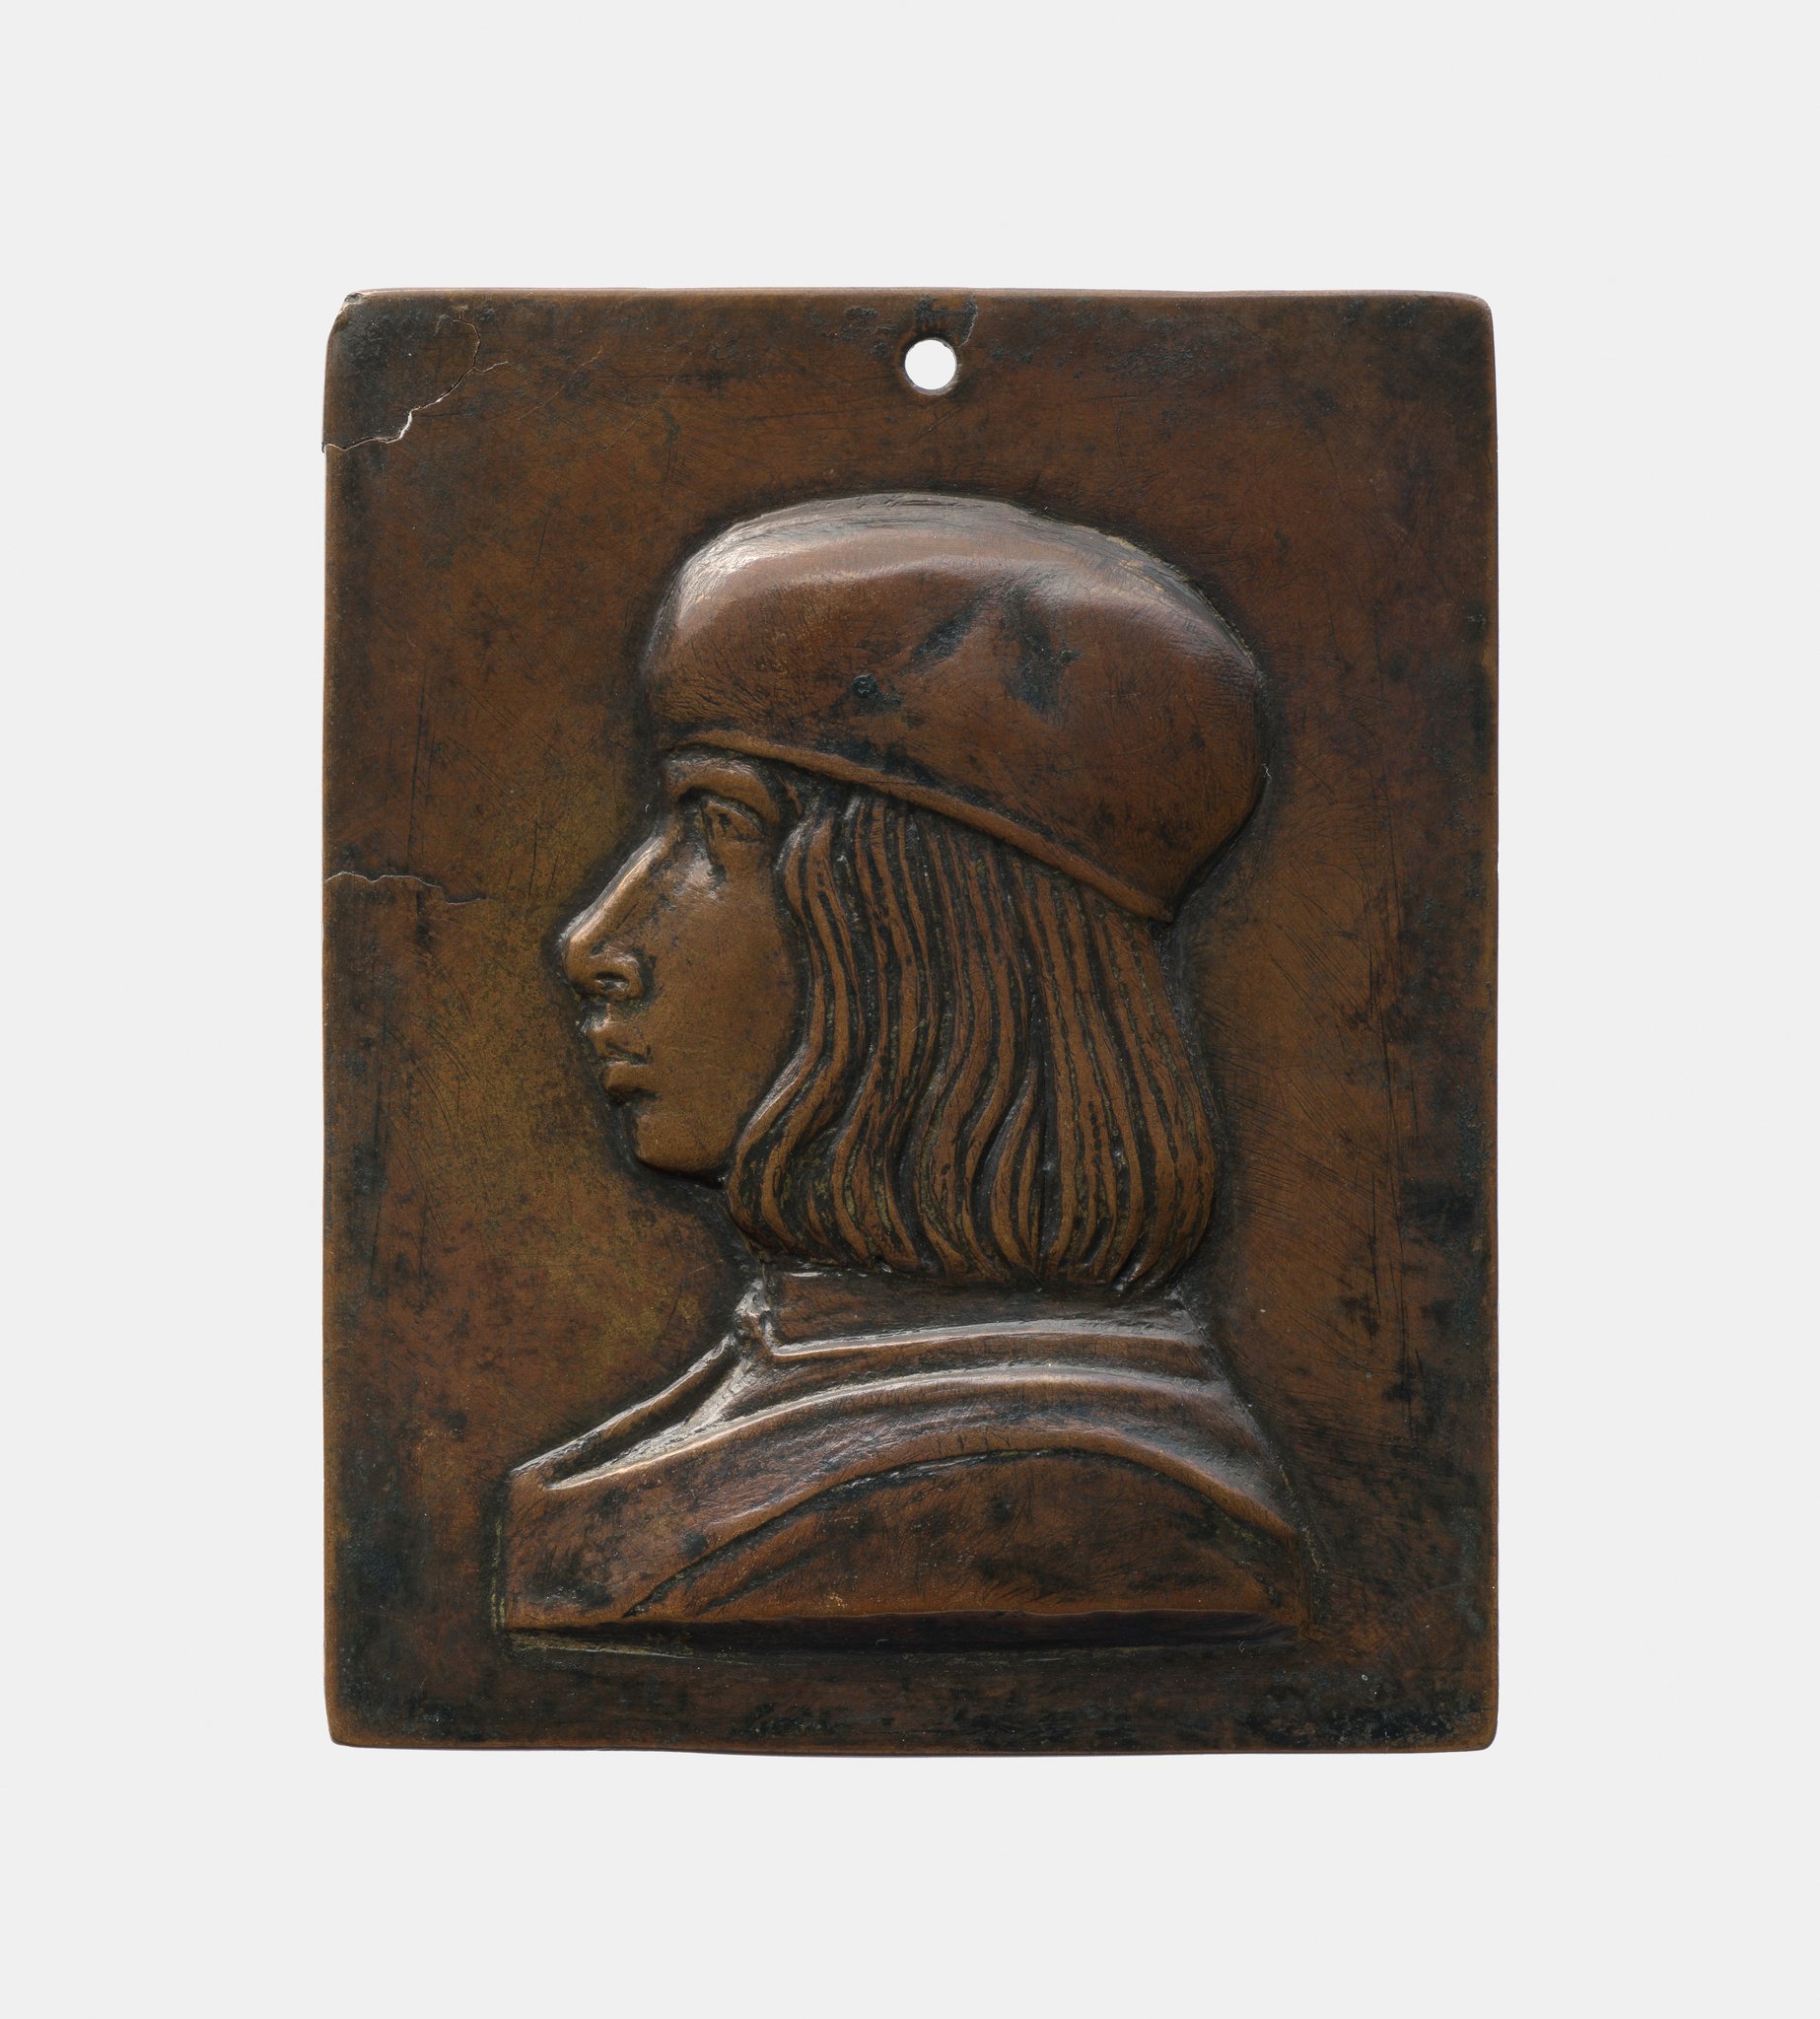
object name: medal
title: Unknown Boy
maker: Anonymous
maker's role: artist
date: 1470-1500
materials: bronze